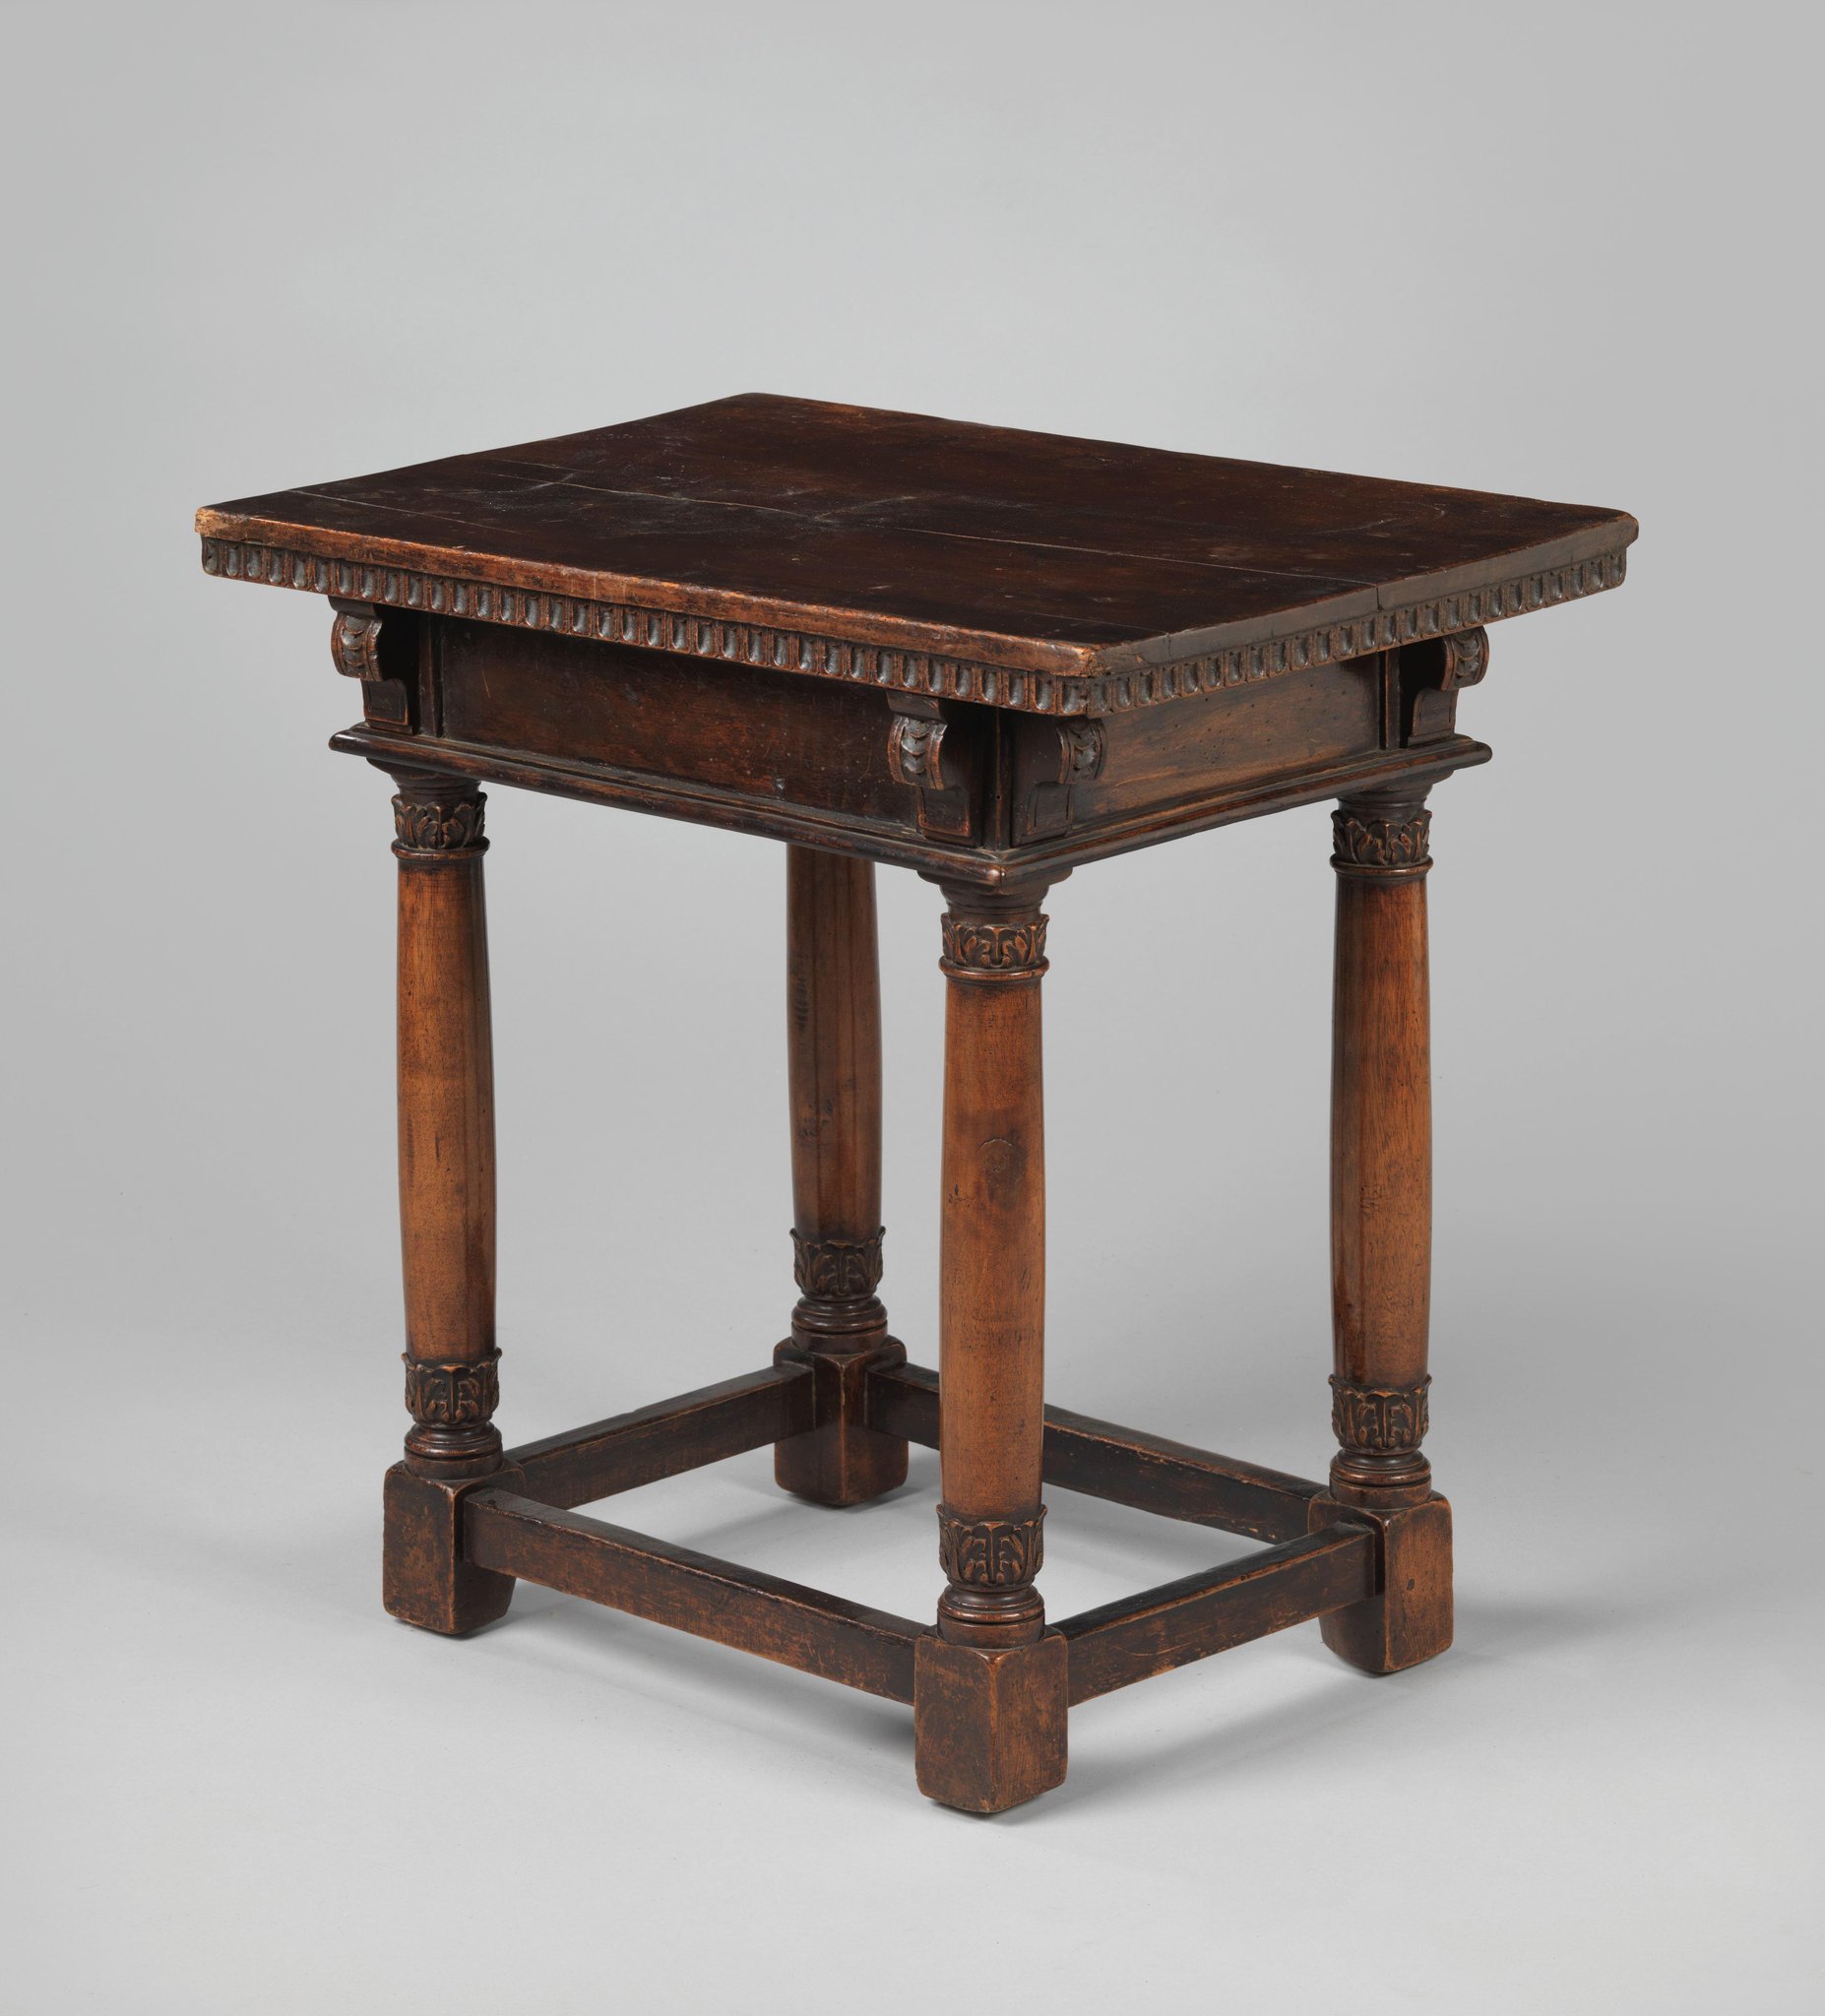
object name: furniture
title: Tafel op vier door regels verbonden kolompoten met bladwerkversiering. In voorregel een lade met trekker.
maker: Anonymous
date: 1500-1599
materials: wood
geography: italy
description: Tafel van notenhout, rustend op vier door regels verbonden kolompoten. De zuilen zijn onder en boven met bladwerk versierd. In de voorregel een lade met trekker, geflankeerd door twee consoles. Onder het blad is een lijst van halve knorren aangebracht.